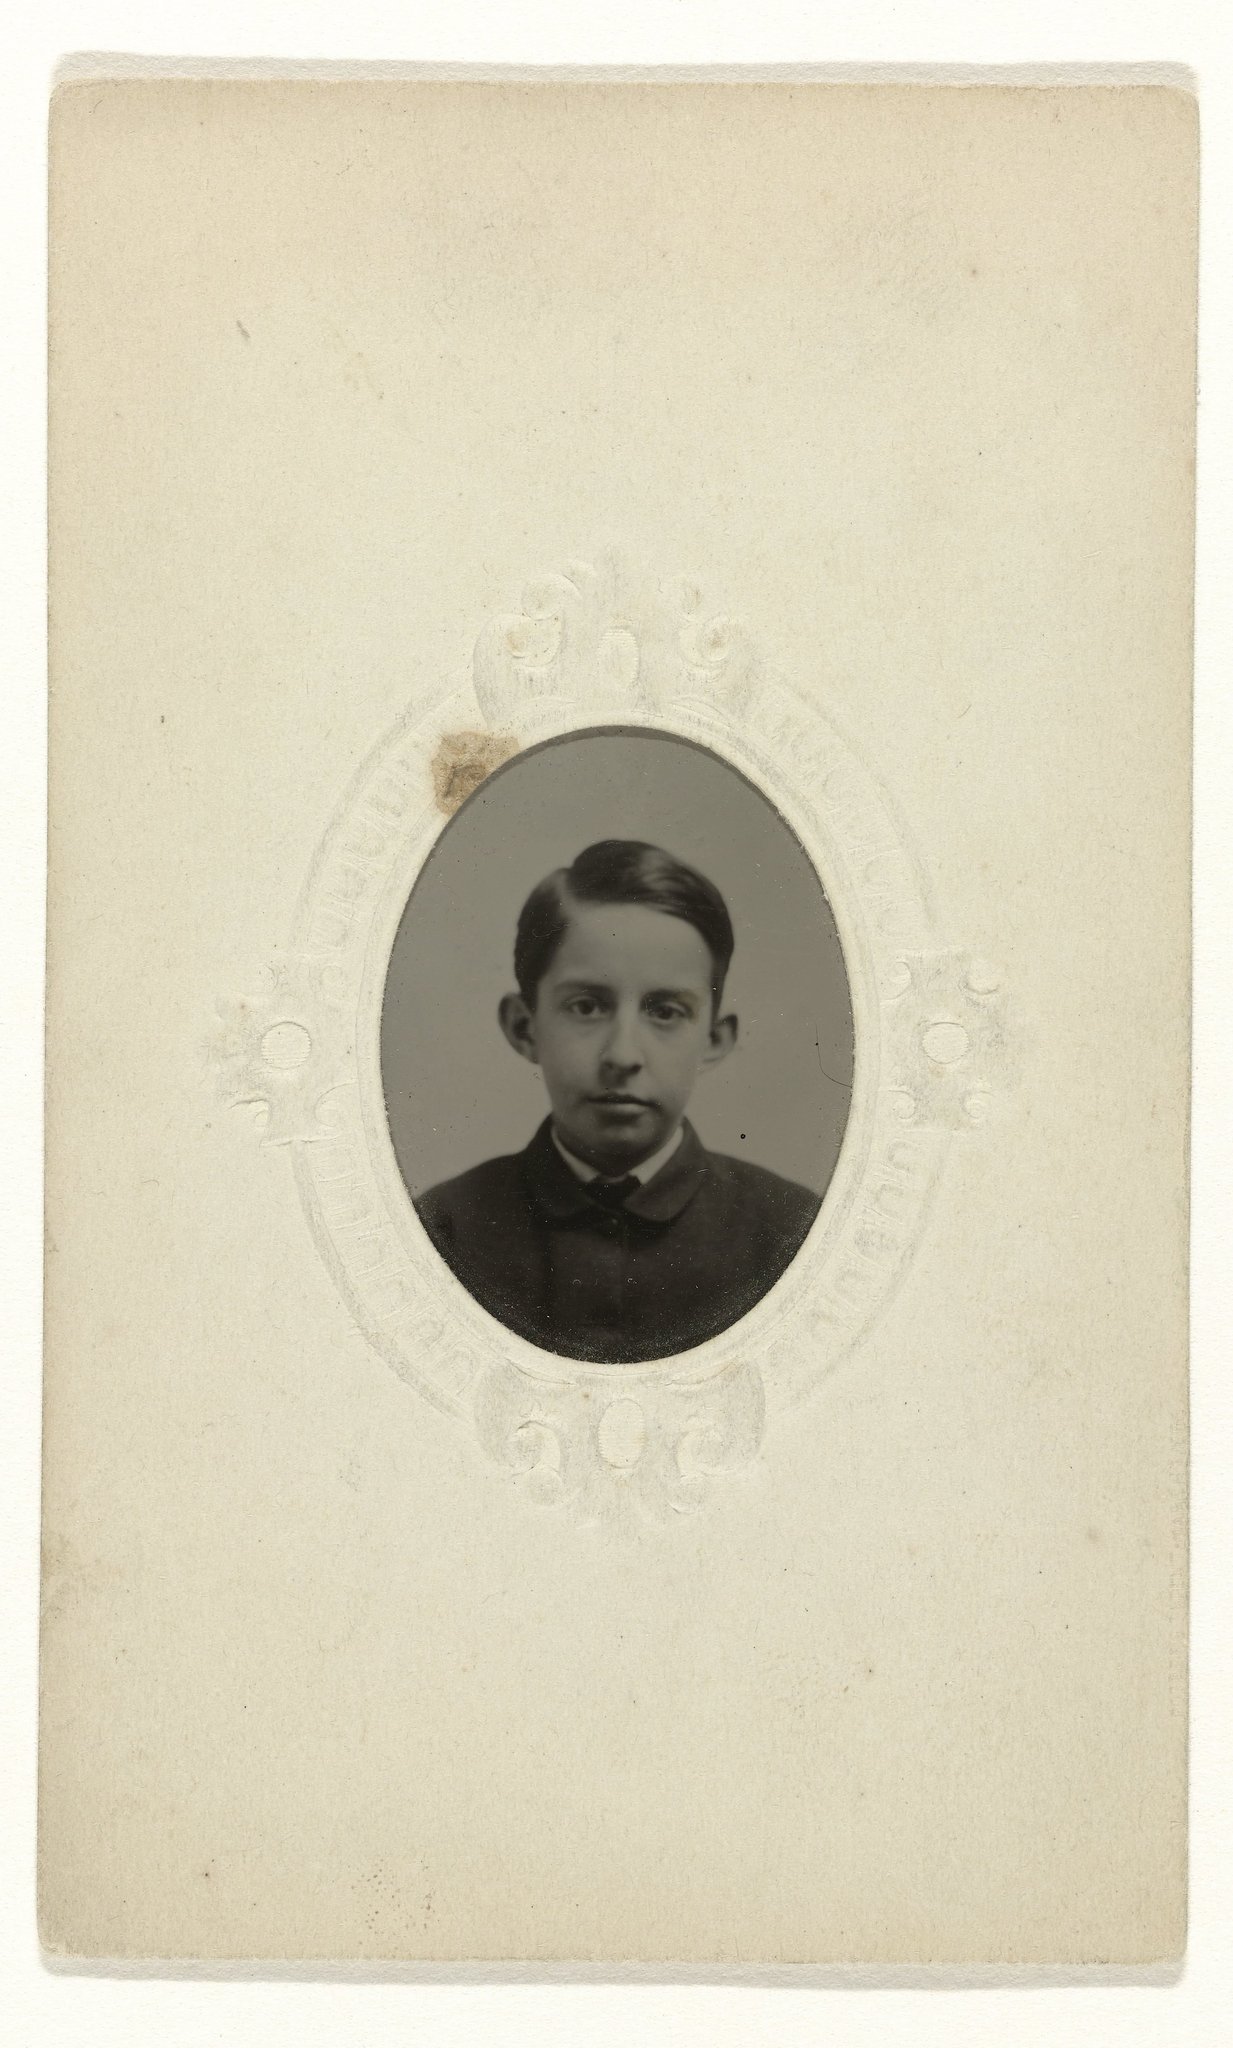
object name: photograph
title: Portret van een jongen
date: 1860-1890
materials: metal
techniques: ferrotyping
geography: united states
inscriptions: annotation: ‘TAYLOR & CO., / ferrotypes, / 105 Fulton Avenue, BROOKLYN. / Pictures taken in all kinds of / weather, and finished in / 10 minutes.’